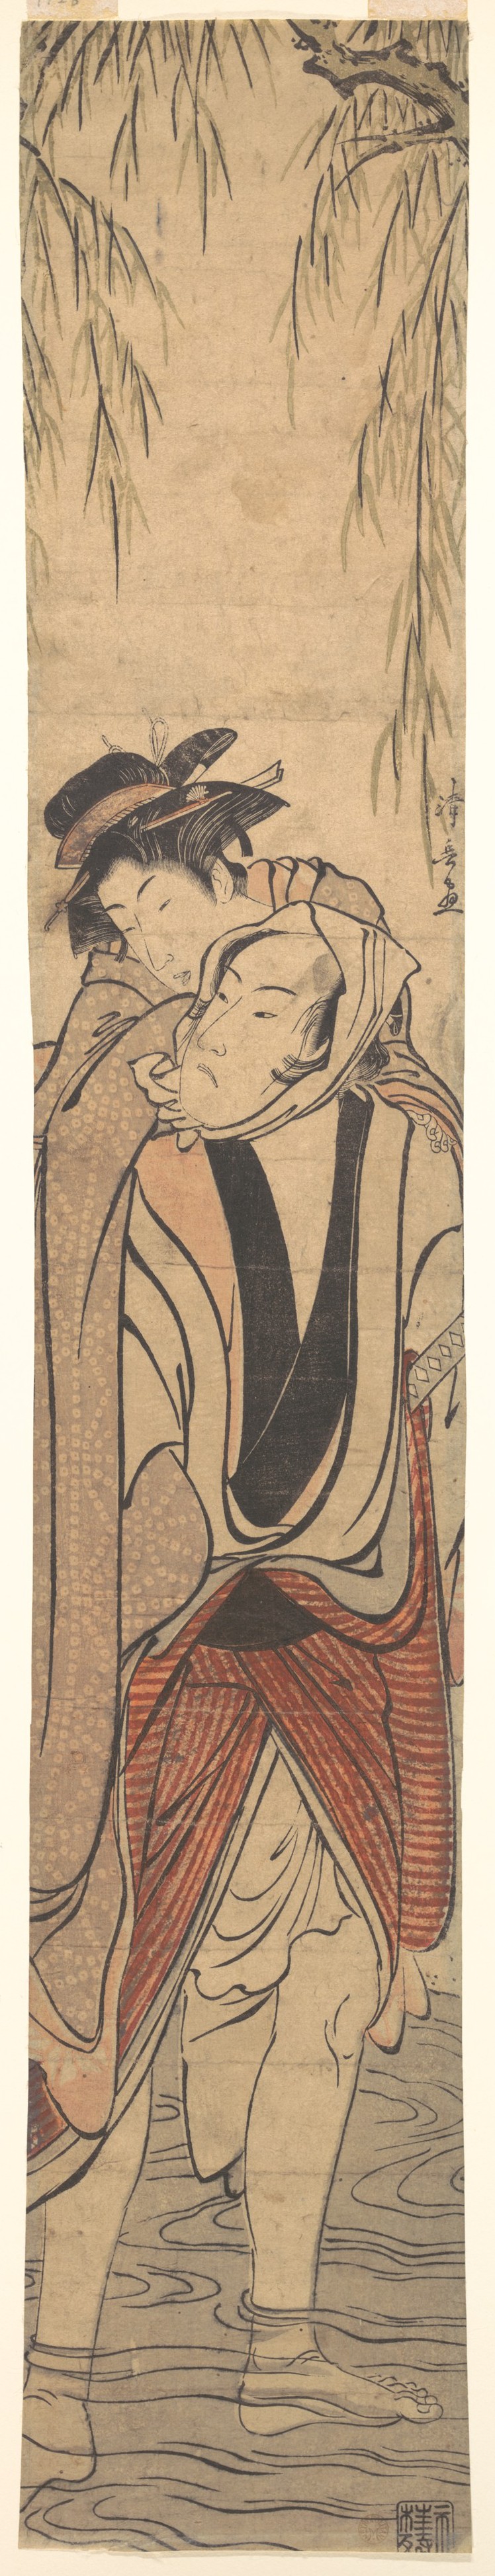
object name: print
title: Two Lovers Crossing a River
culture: japanese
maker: torii kiyonaga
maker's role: artist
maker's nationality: japanese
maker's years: 1752-1815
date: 1767-1800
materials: ink, paper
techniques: polychrome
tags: men,lovers,women,rivers